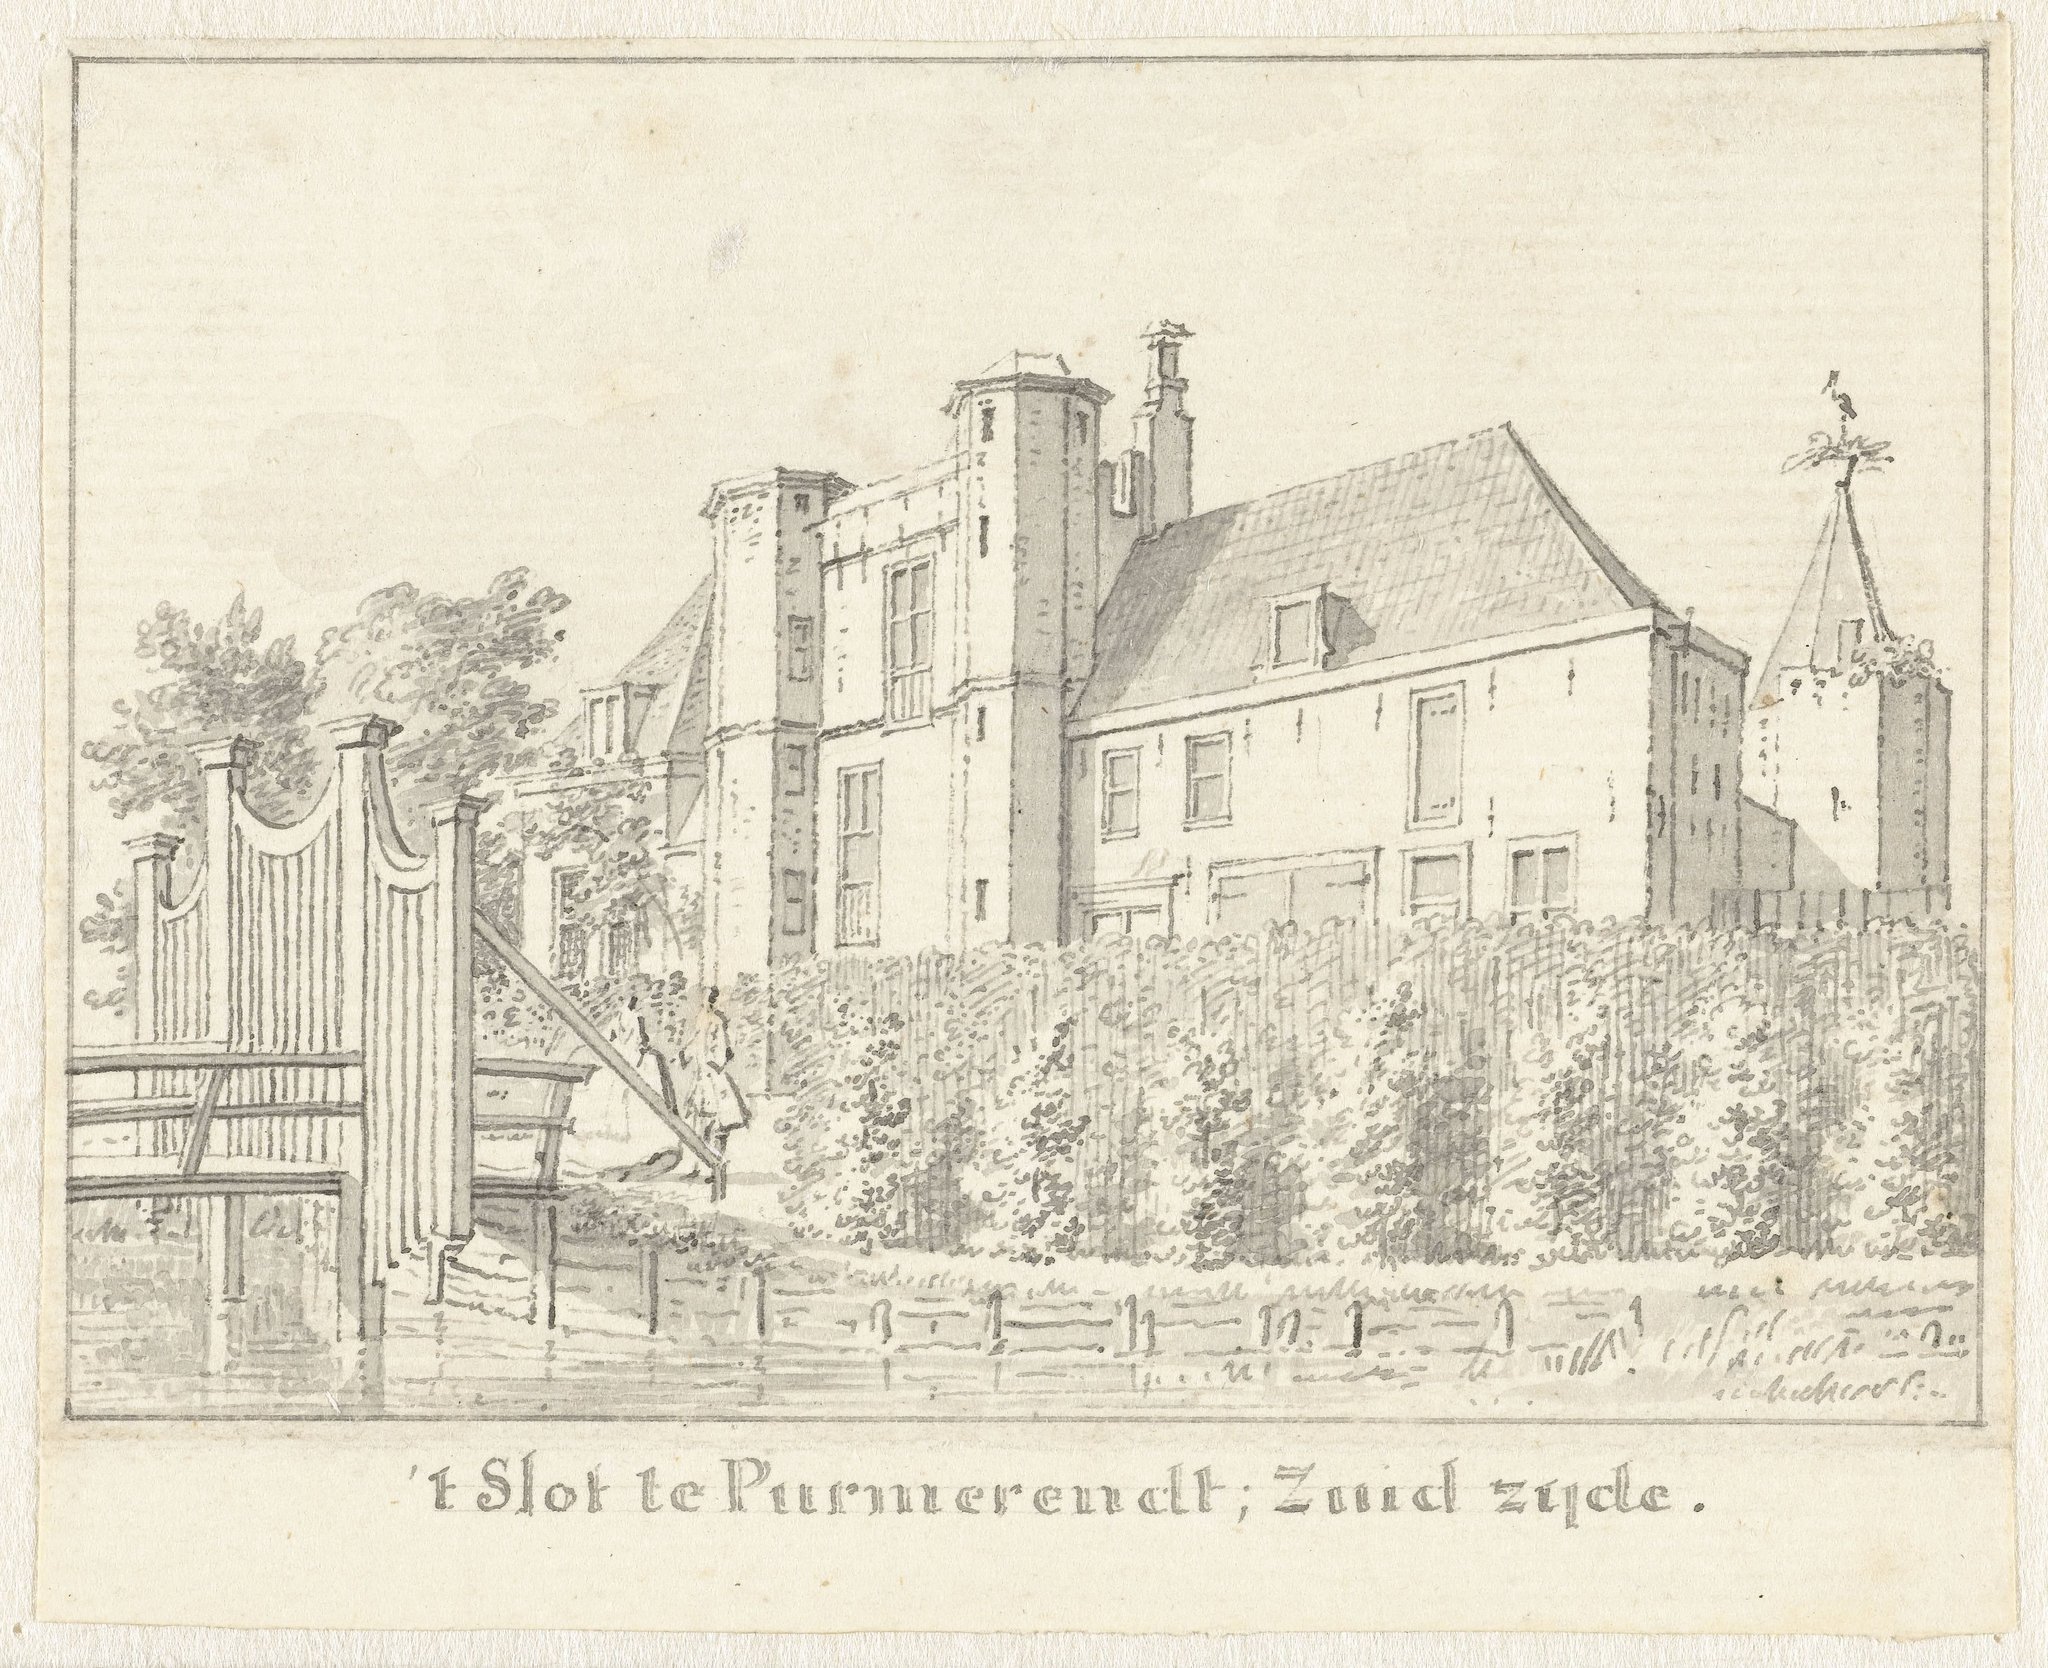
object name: design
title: Het slot te Purmerend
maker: cornelis pronk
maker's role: draughtsman, painter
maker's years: 1691-1759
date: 1701-1759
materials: ink, paper, pencil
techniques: brush, pen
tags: castle